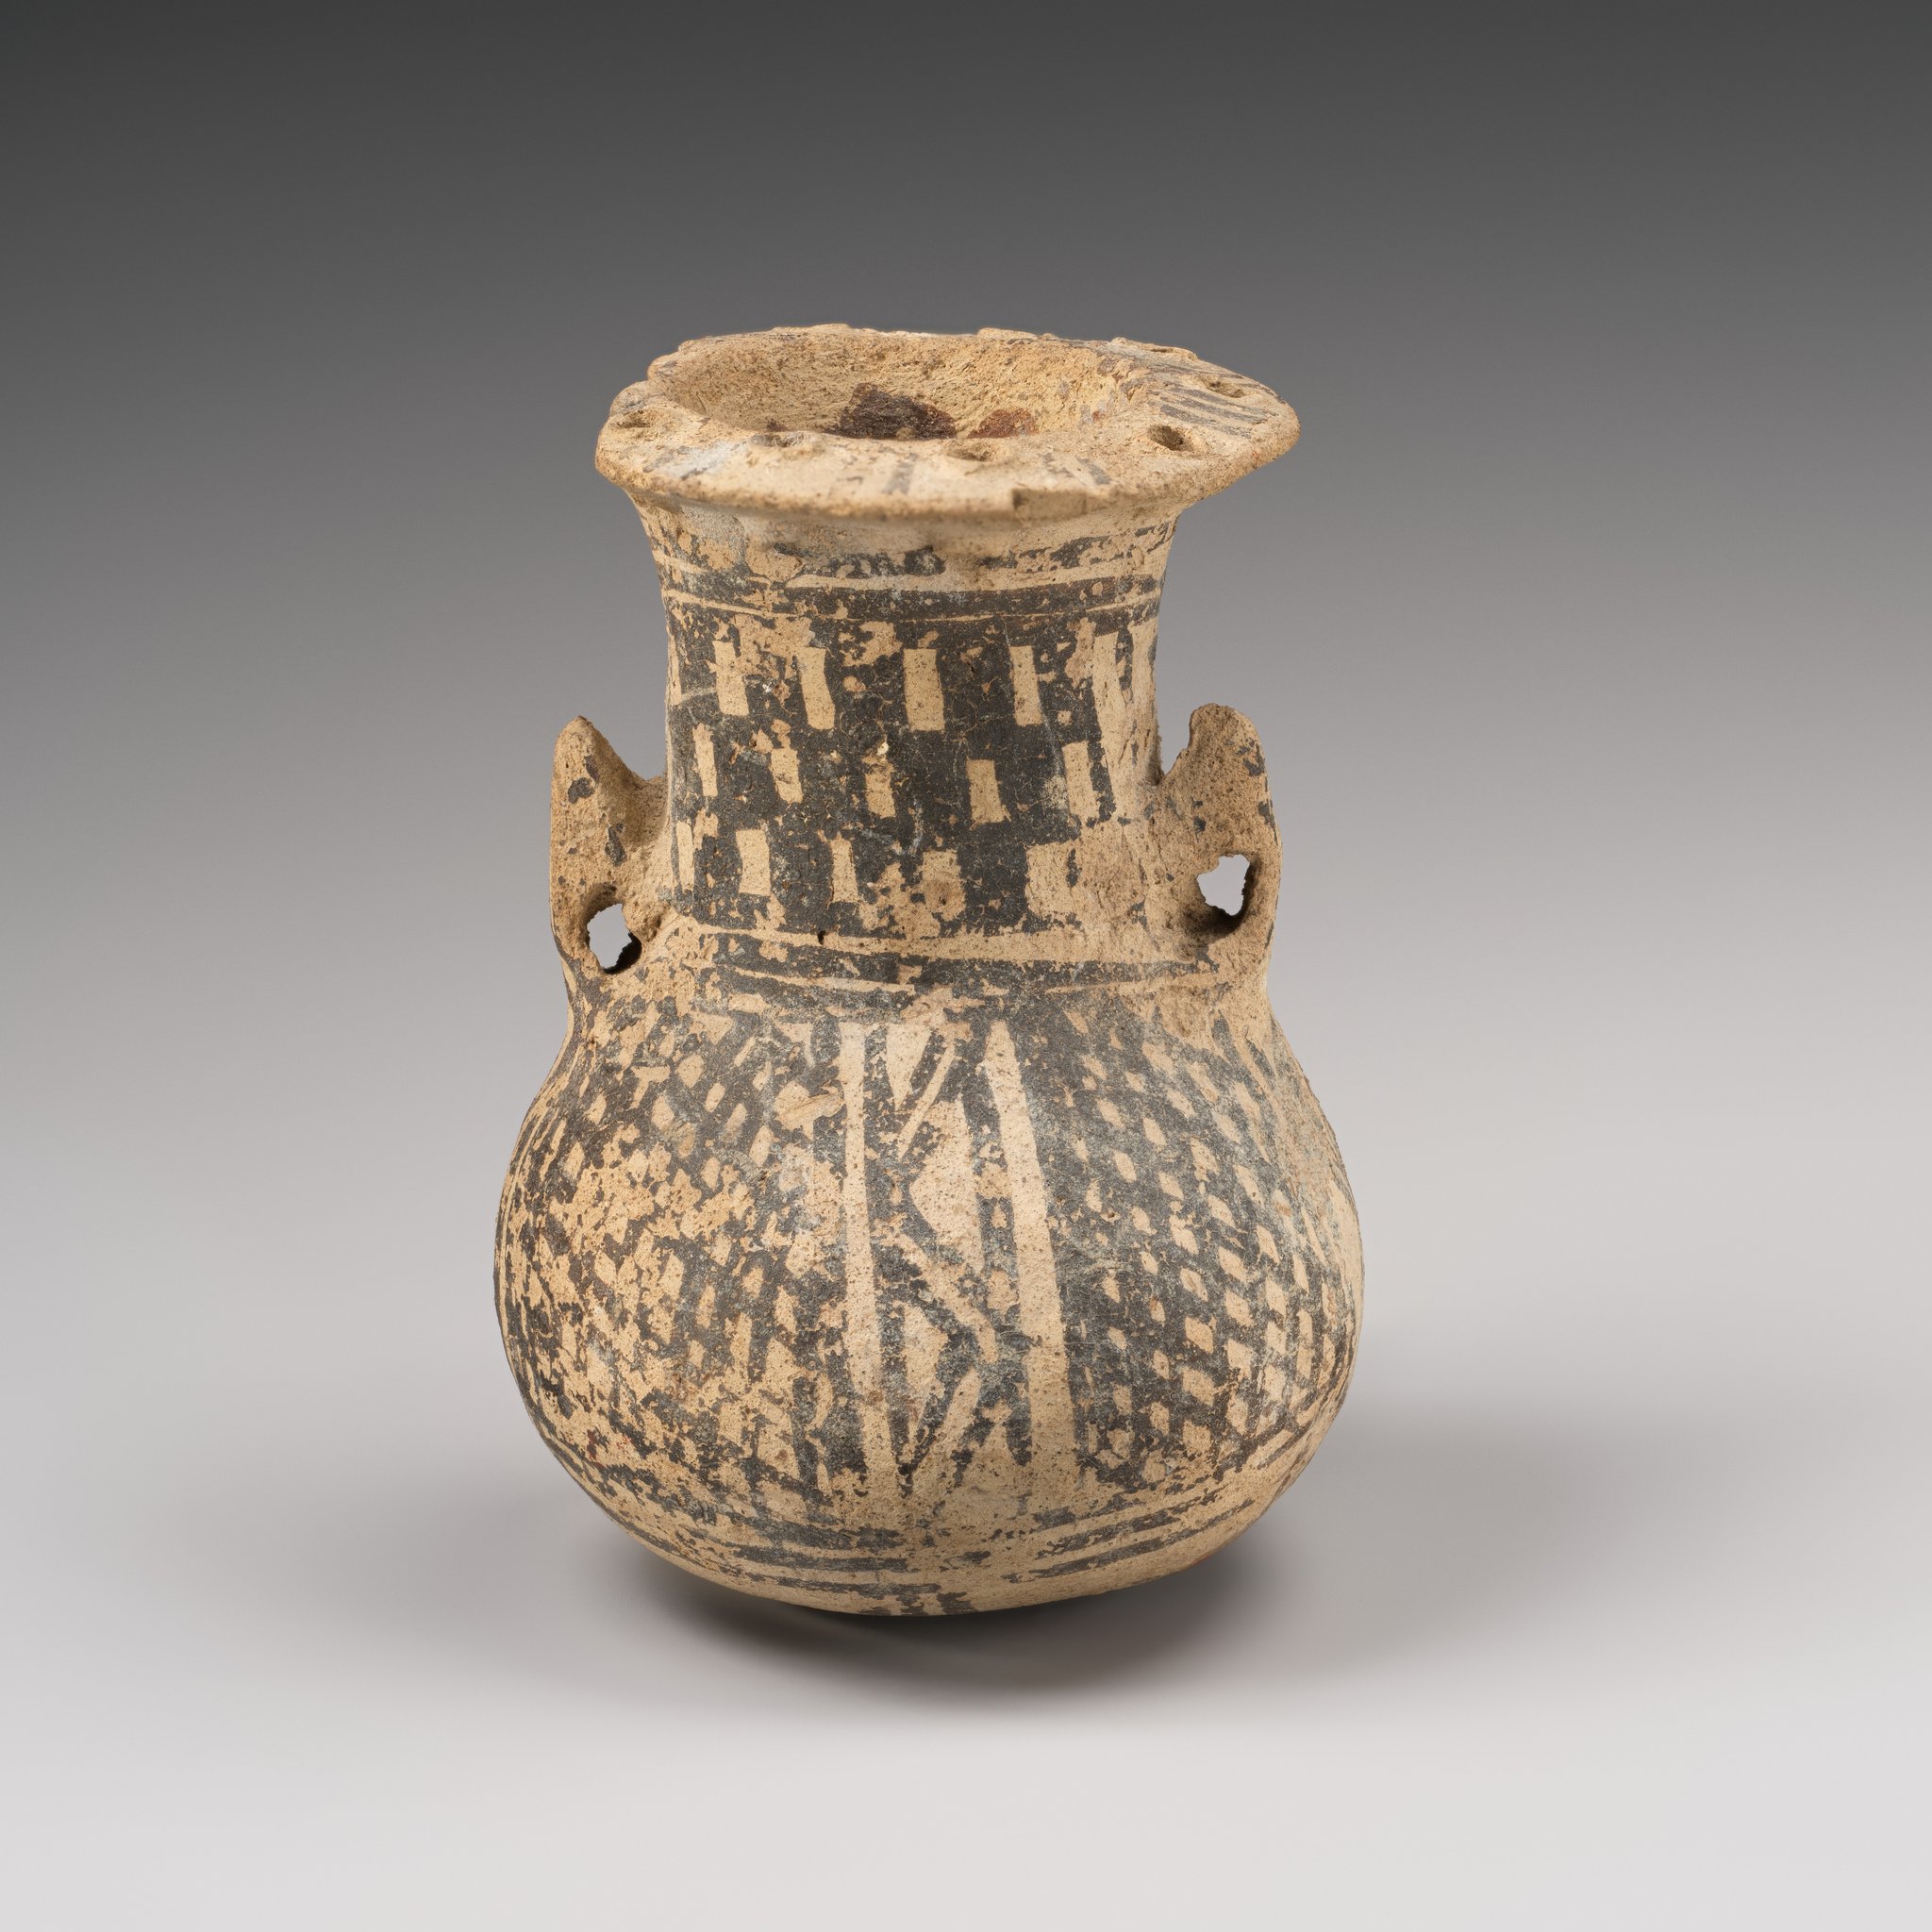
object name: amphora, miniature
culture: cypriot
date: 1900-1600 BCE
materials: terracotta